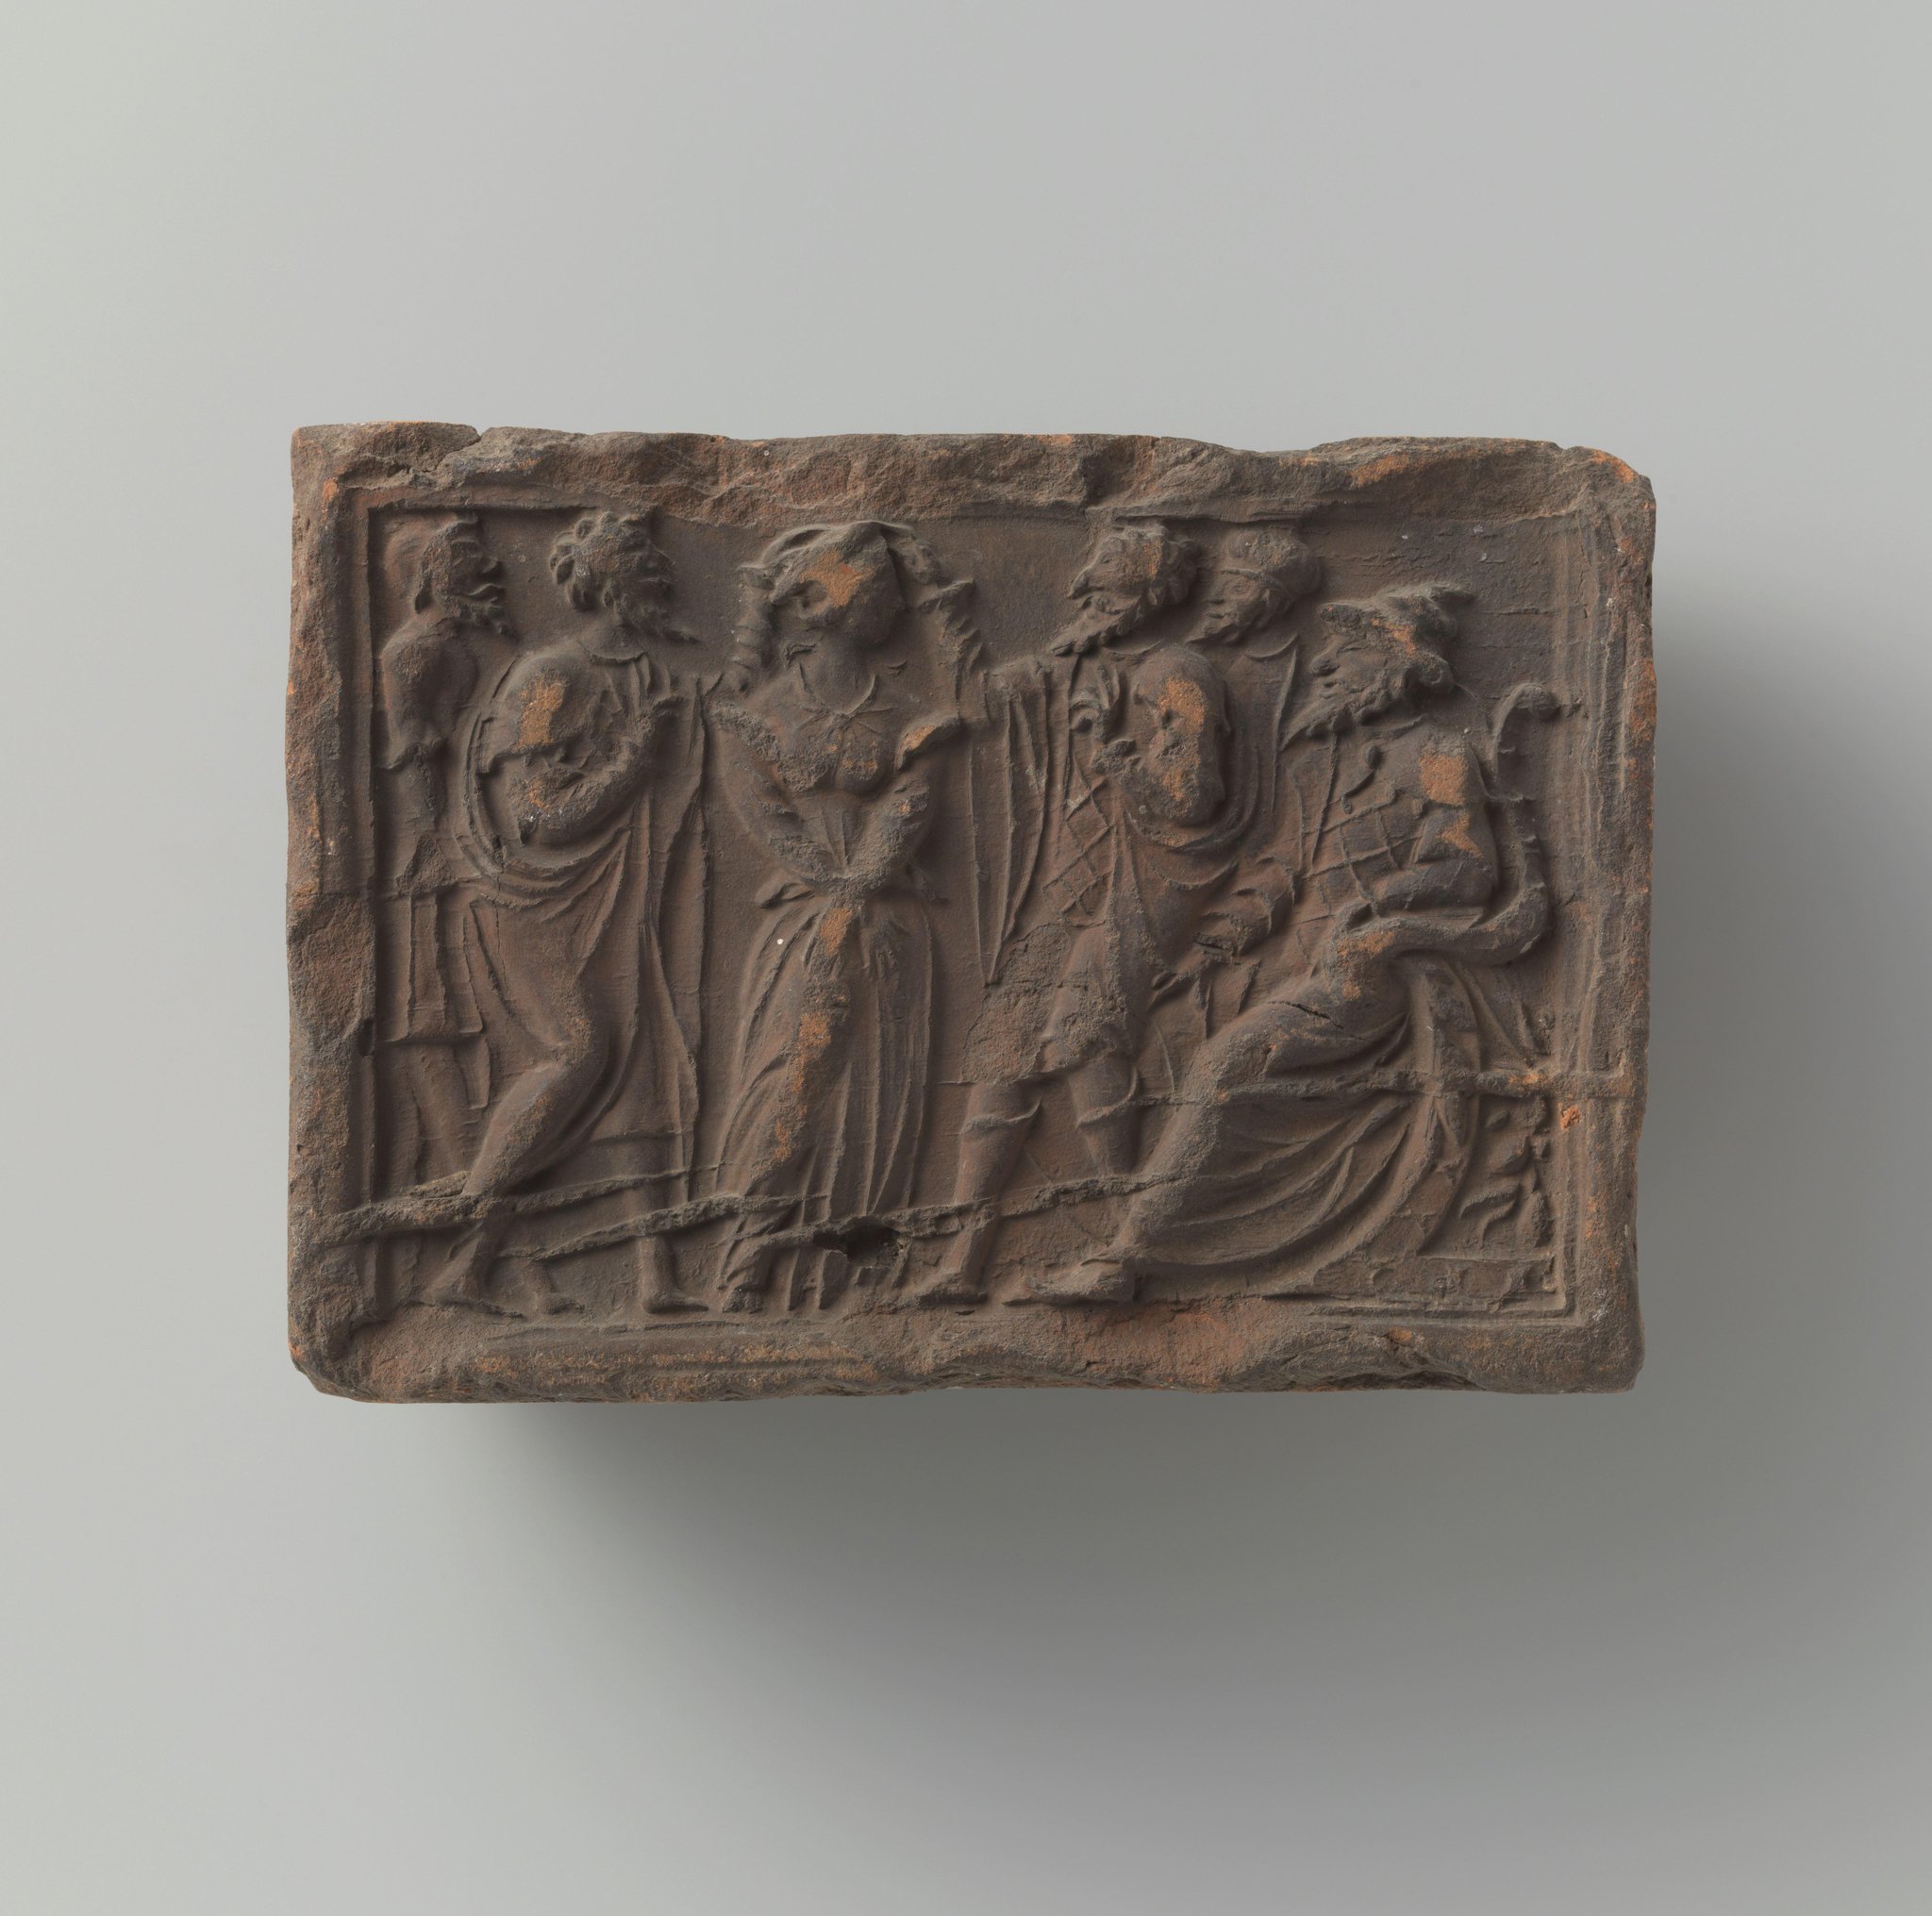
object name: hearthstone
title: Haardsteen met voorstelling van Suzanna, die door de twee ouderlingen voor de rechter wordt gevoerd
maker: Anonymous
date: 1550-1600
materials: earthenware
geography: southern netherlands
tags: the elders accusing susanna before the people, laying their hands on her head or unveiling her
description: Haardsteen met voorstelling van Suzanna, die door de twee ouderlingen voor de rechter wordt gevoerd.